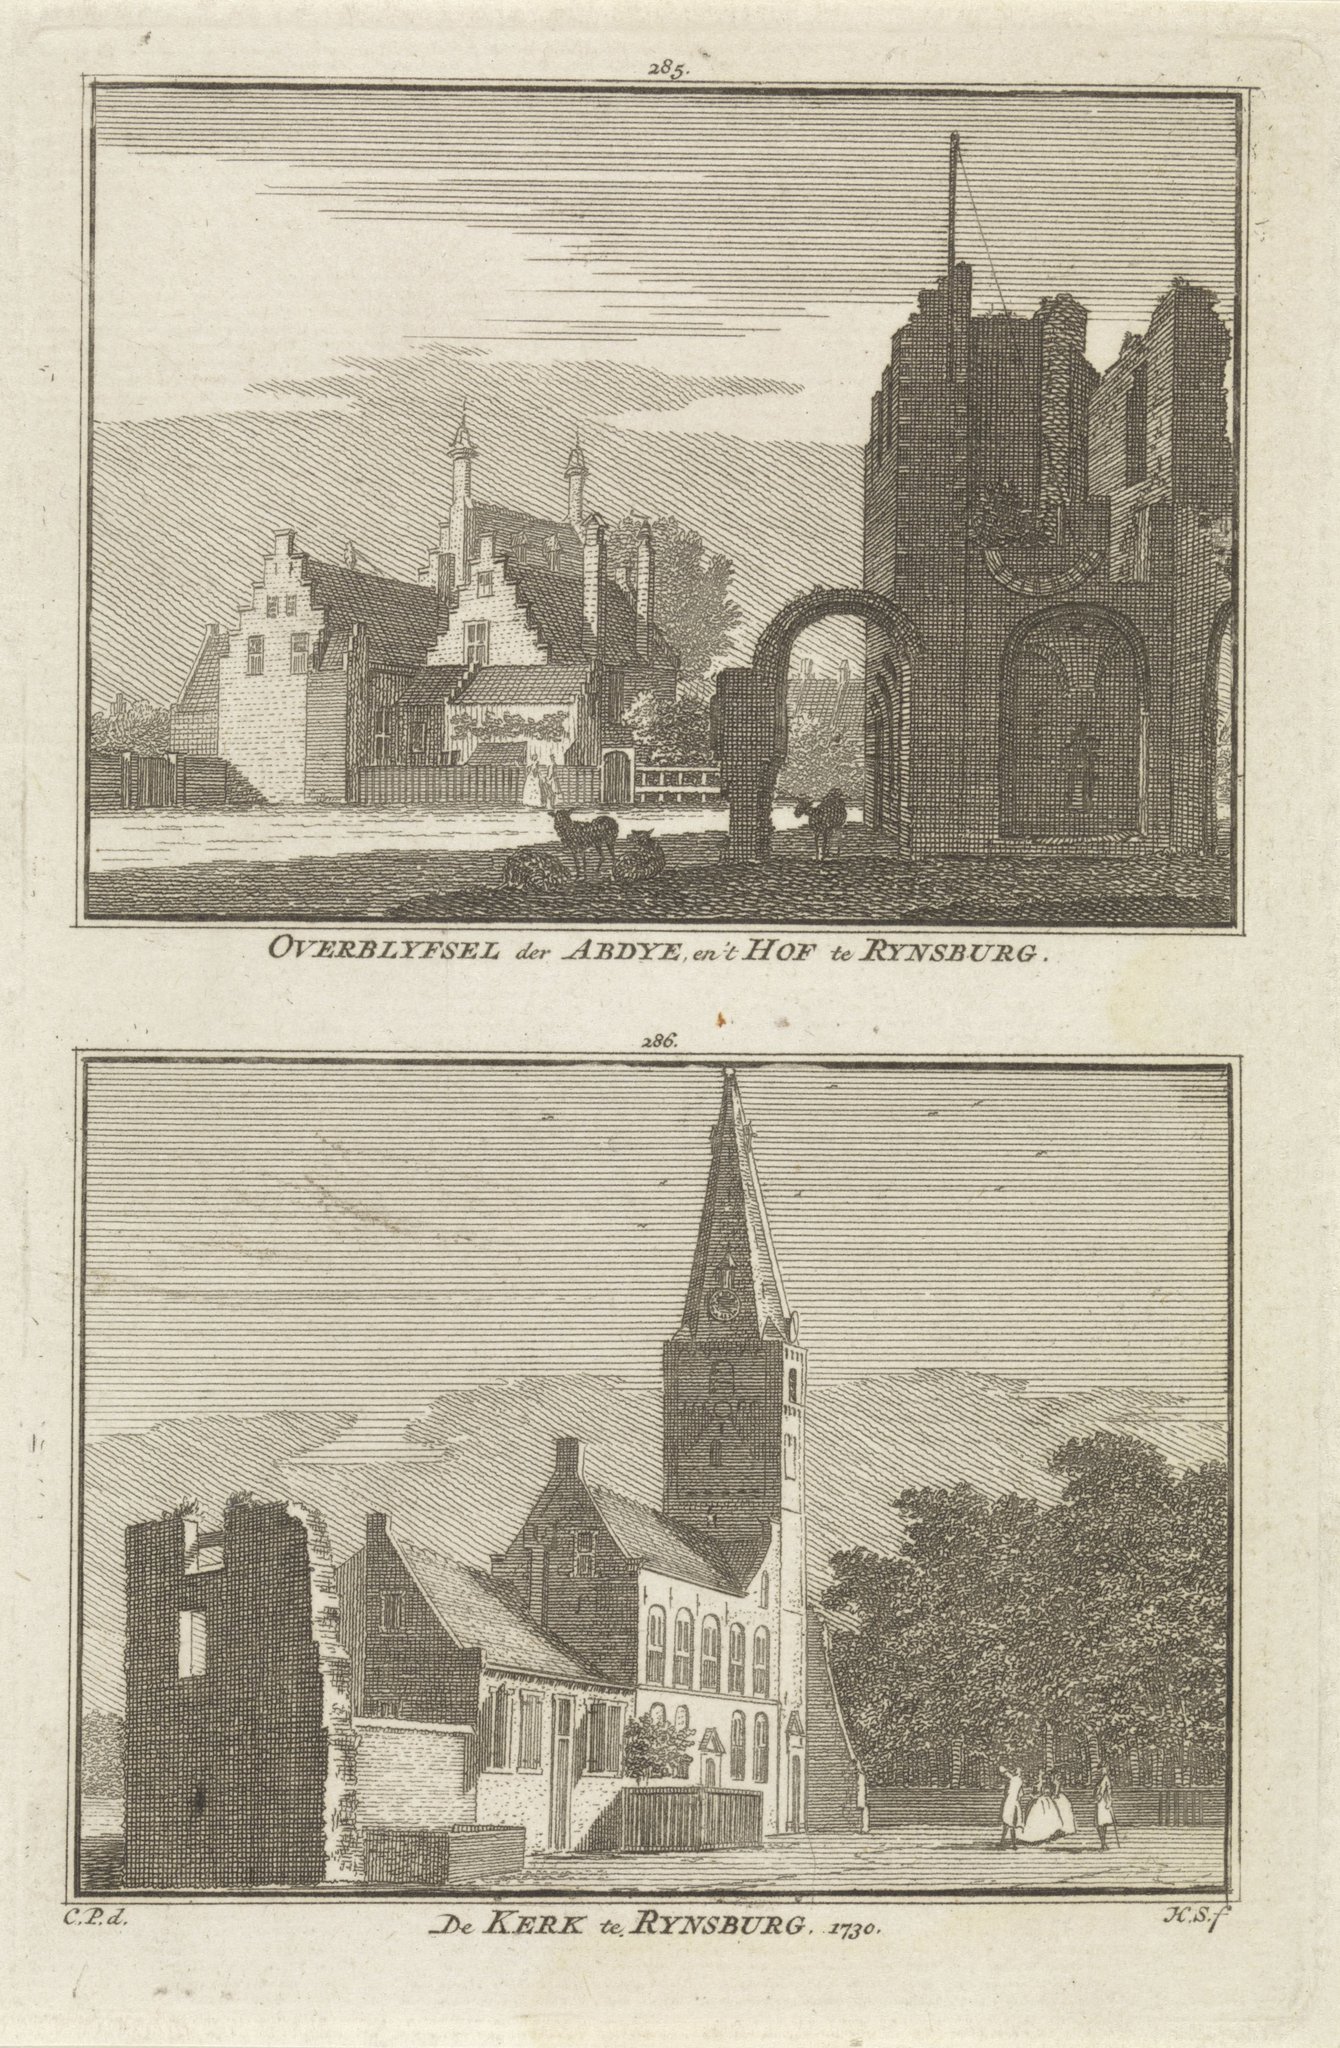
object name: print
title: Overblyfsel der Abdye en 't Hof te Rynsburg/ De Kerk te Rynsburg 1730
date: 1750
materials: paper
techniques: etching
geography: haarlem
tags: church (exterior), ruin of church, monastery, etc., prospect of city, town panorama, silhouette of city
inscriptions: collector's mark: Lugt 2228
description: Prent gebruikt in: Het verheerlykt Nederland of kabinet van hedendaagsche gezigten van steden, dorpen, sloten ... en andere voornaame stad- en landgebouwen, in en omtrent alle de byzondere Vereenigde Nederlandsche Provinciën : gedurende de laatste jaaren door vermaarden kunsttekenaren na het leven getekent en ... in 't koper gebragt ... dienende tot opheldering der beschryvinge van den Tegenwoordigen Staat der Vereenigde Nederlanden. Deel III, 1750. Amsterdam: Isaac Tirion, 1745-1774.